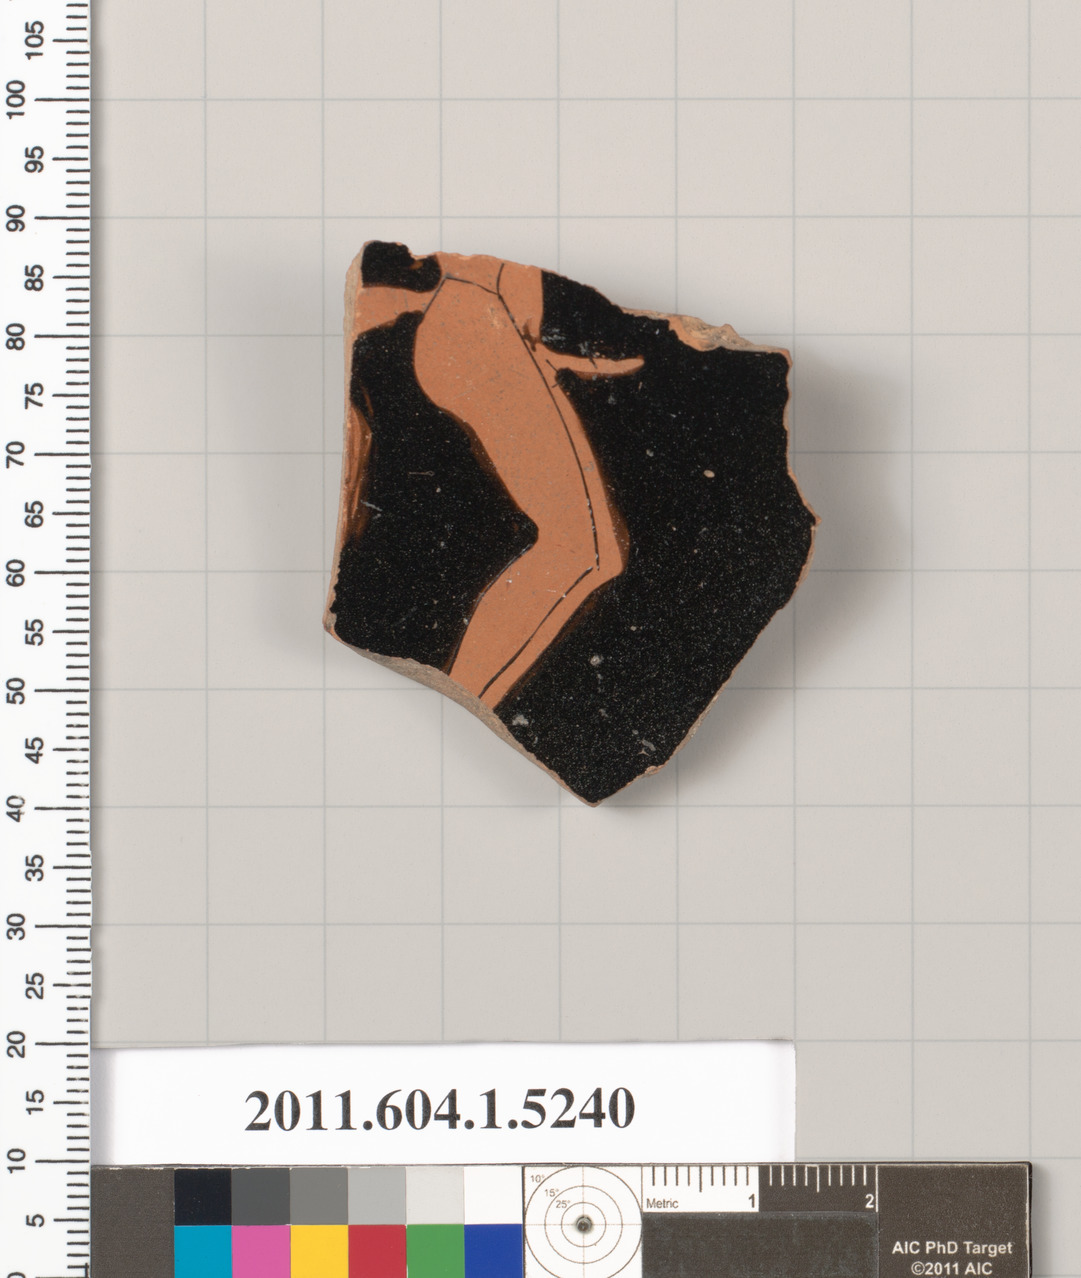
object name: kylix fragment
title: Terracotta fragment of a kylix (drinking cup)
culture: greek, attic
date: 475-451 BCE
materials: terracotta